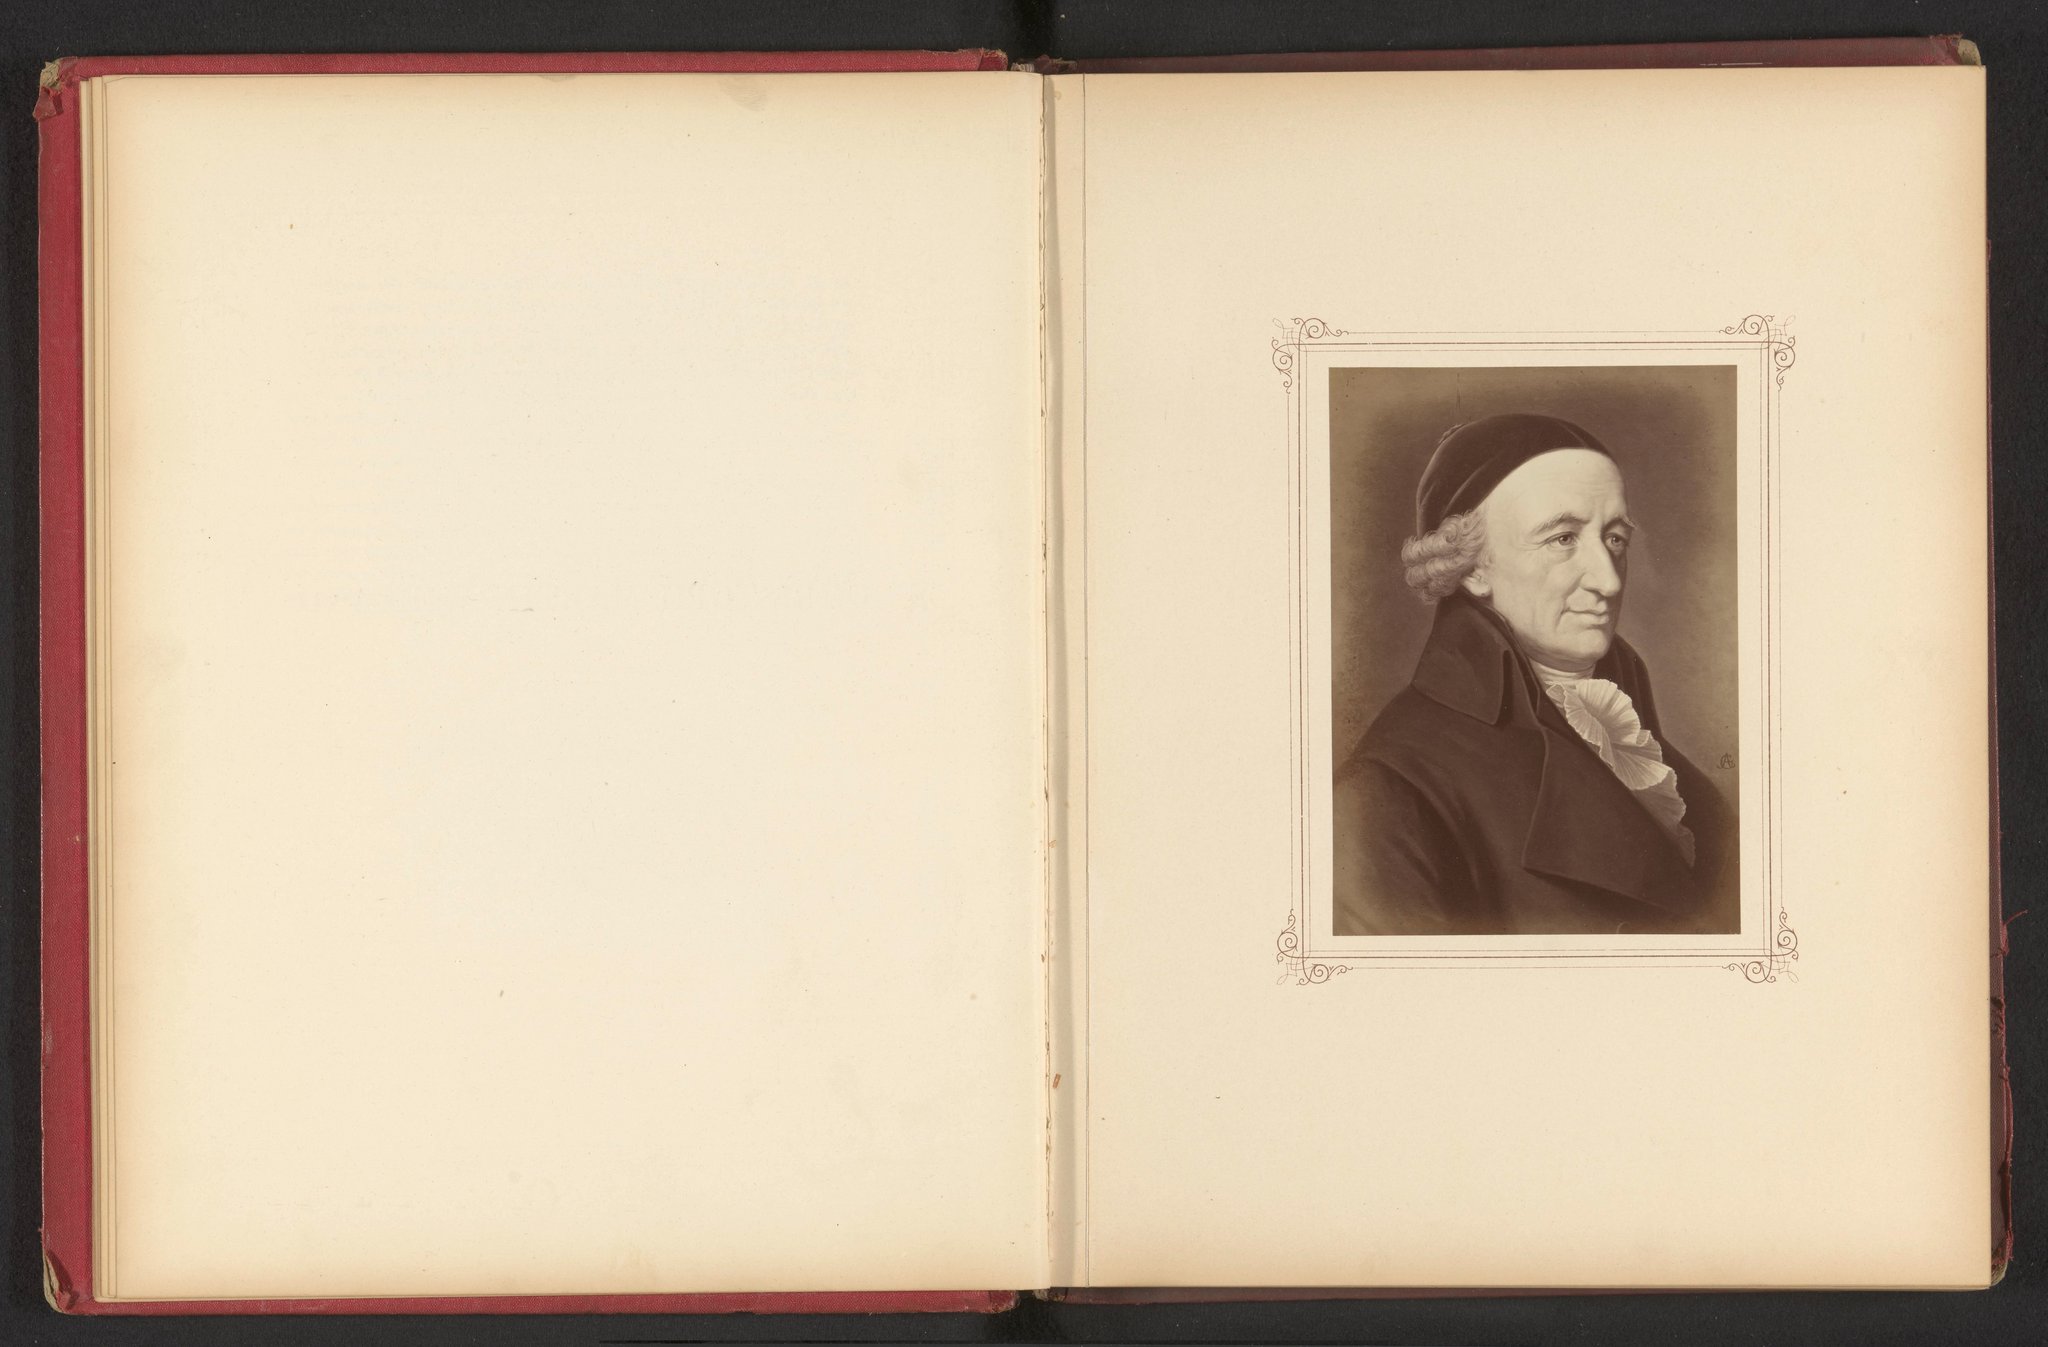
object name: page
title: Fotoreproductie van een portret van Christoph Martin Wieland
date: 1868-1878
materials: photographic support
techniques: albumen print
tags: christoph martin wieland, writer, poet, author